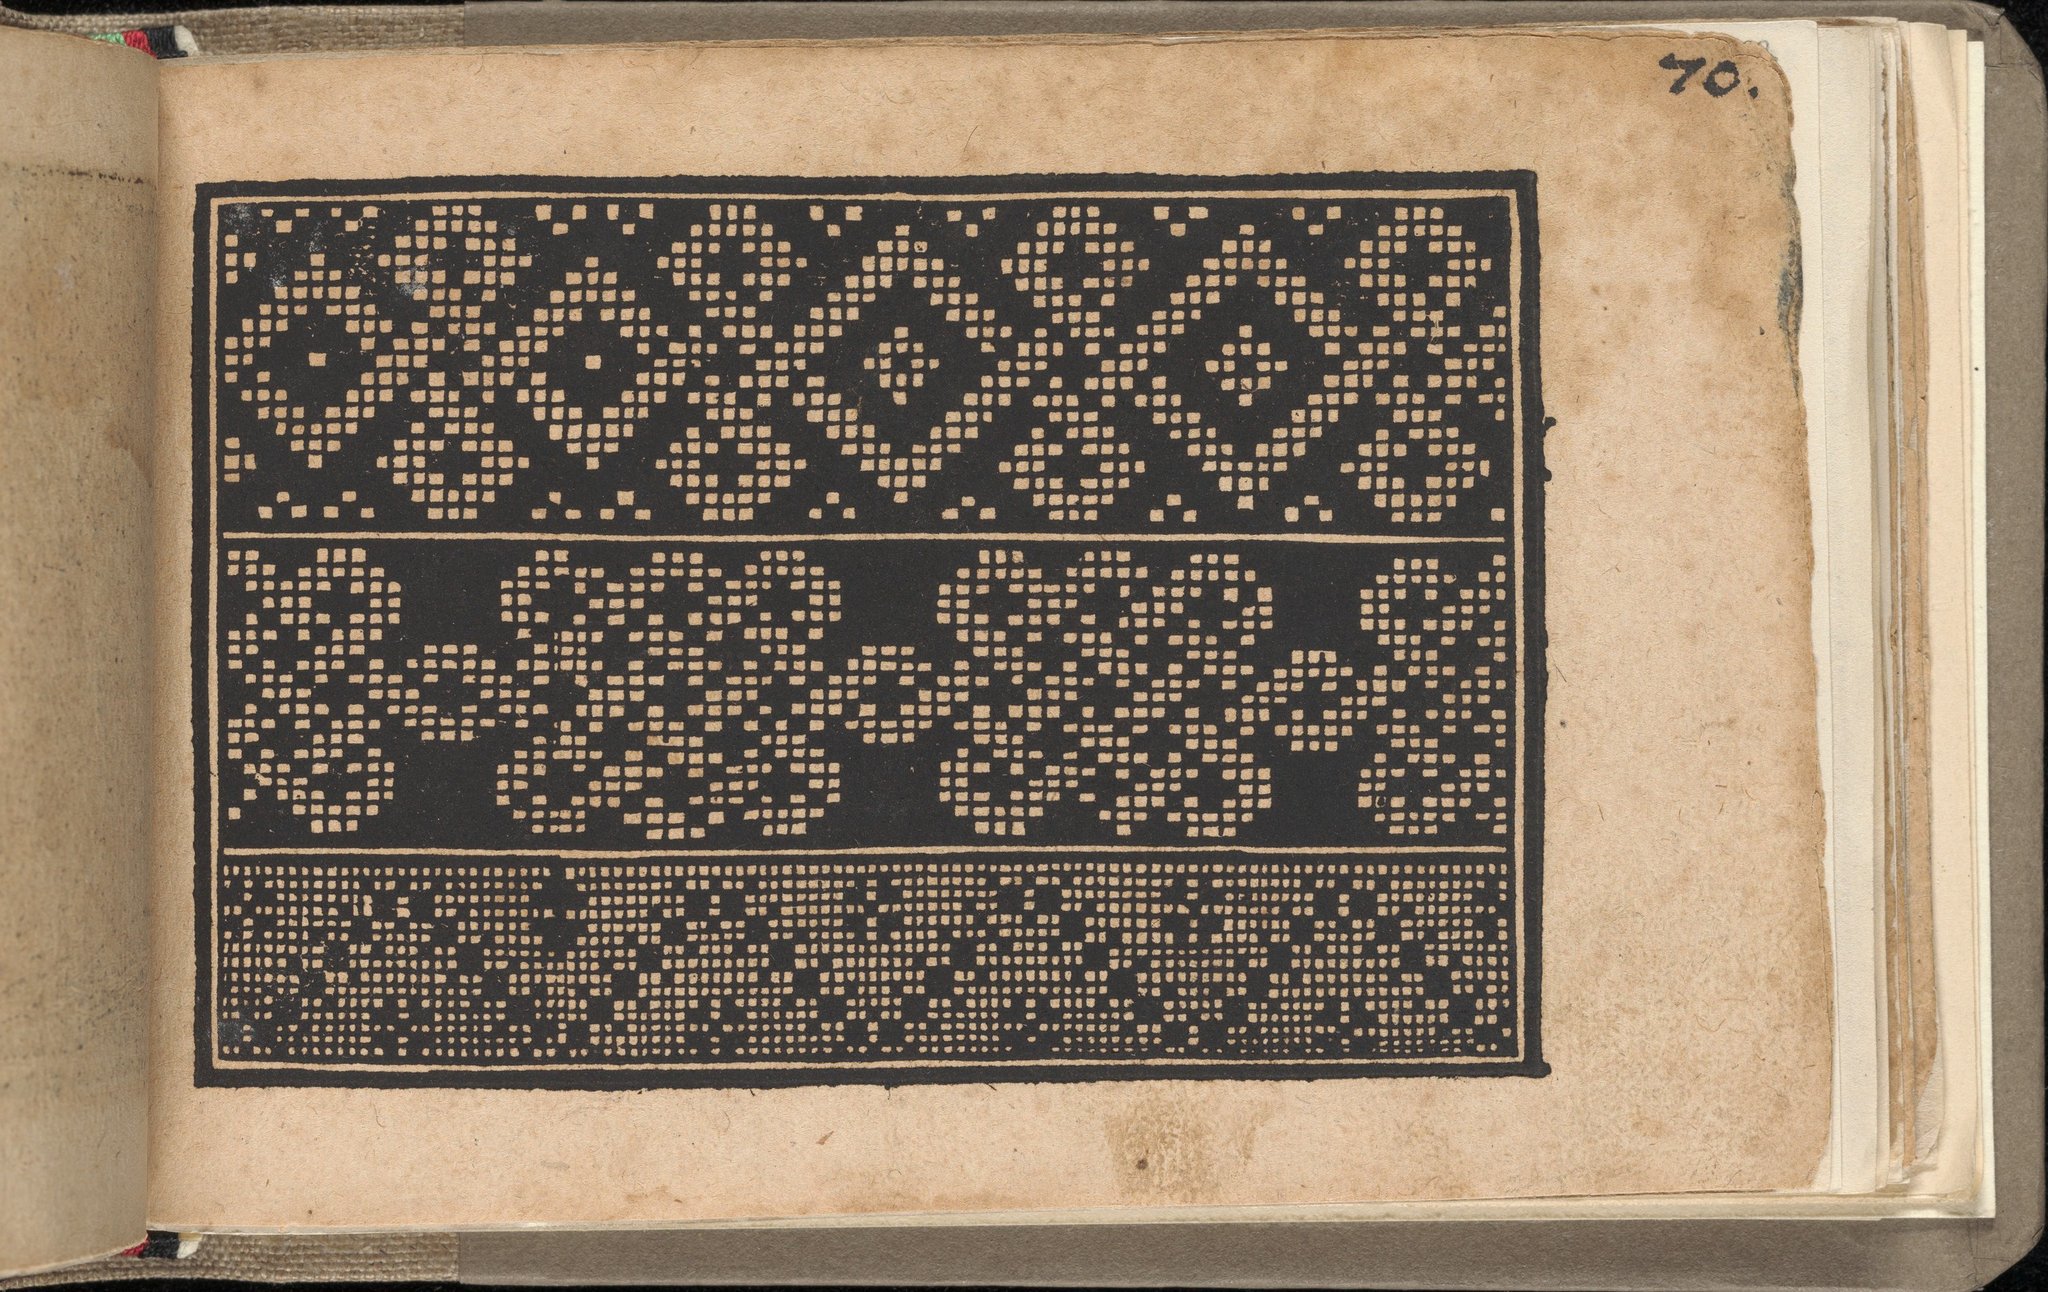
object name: book print ornament architecture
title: Schön newes Modelbuch (Page 70r)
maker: sigismundus latomus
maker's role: publisher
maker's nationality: german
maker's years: 1599-1632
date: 1608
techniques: woodcut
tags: ornament